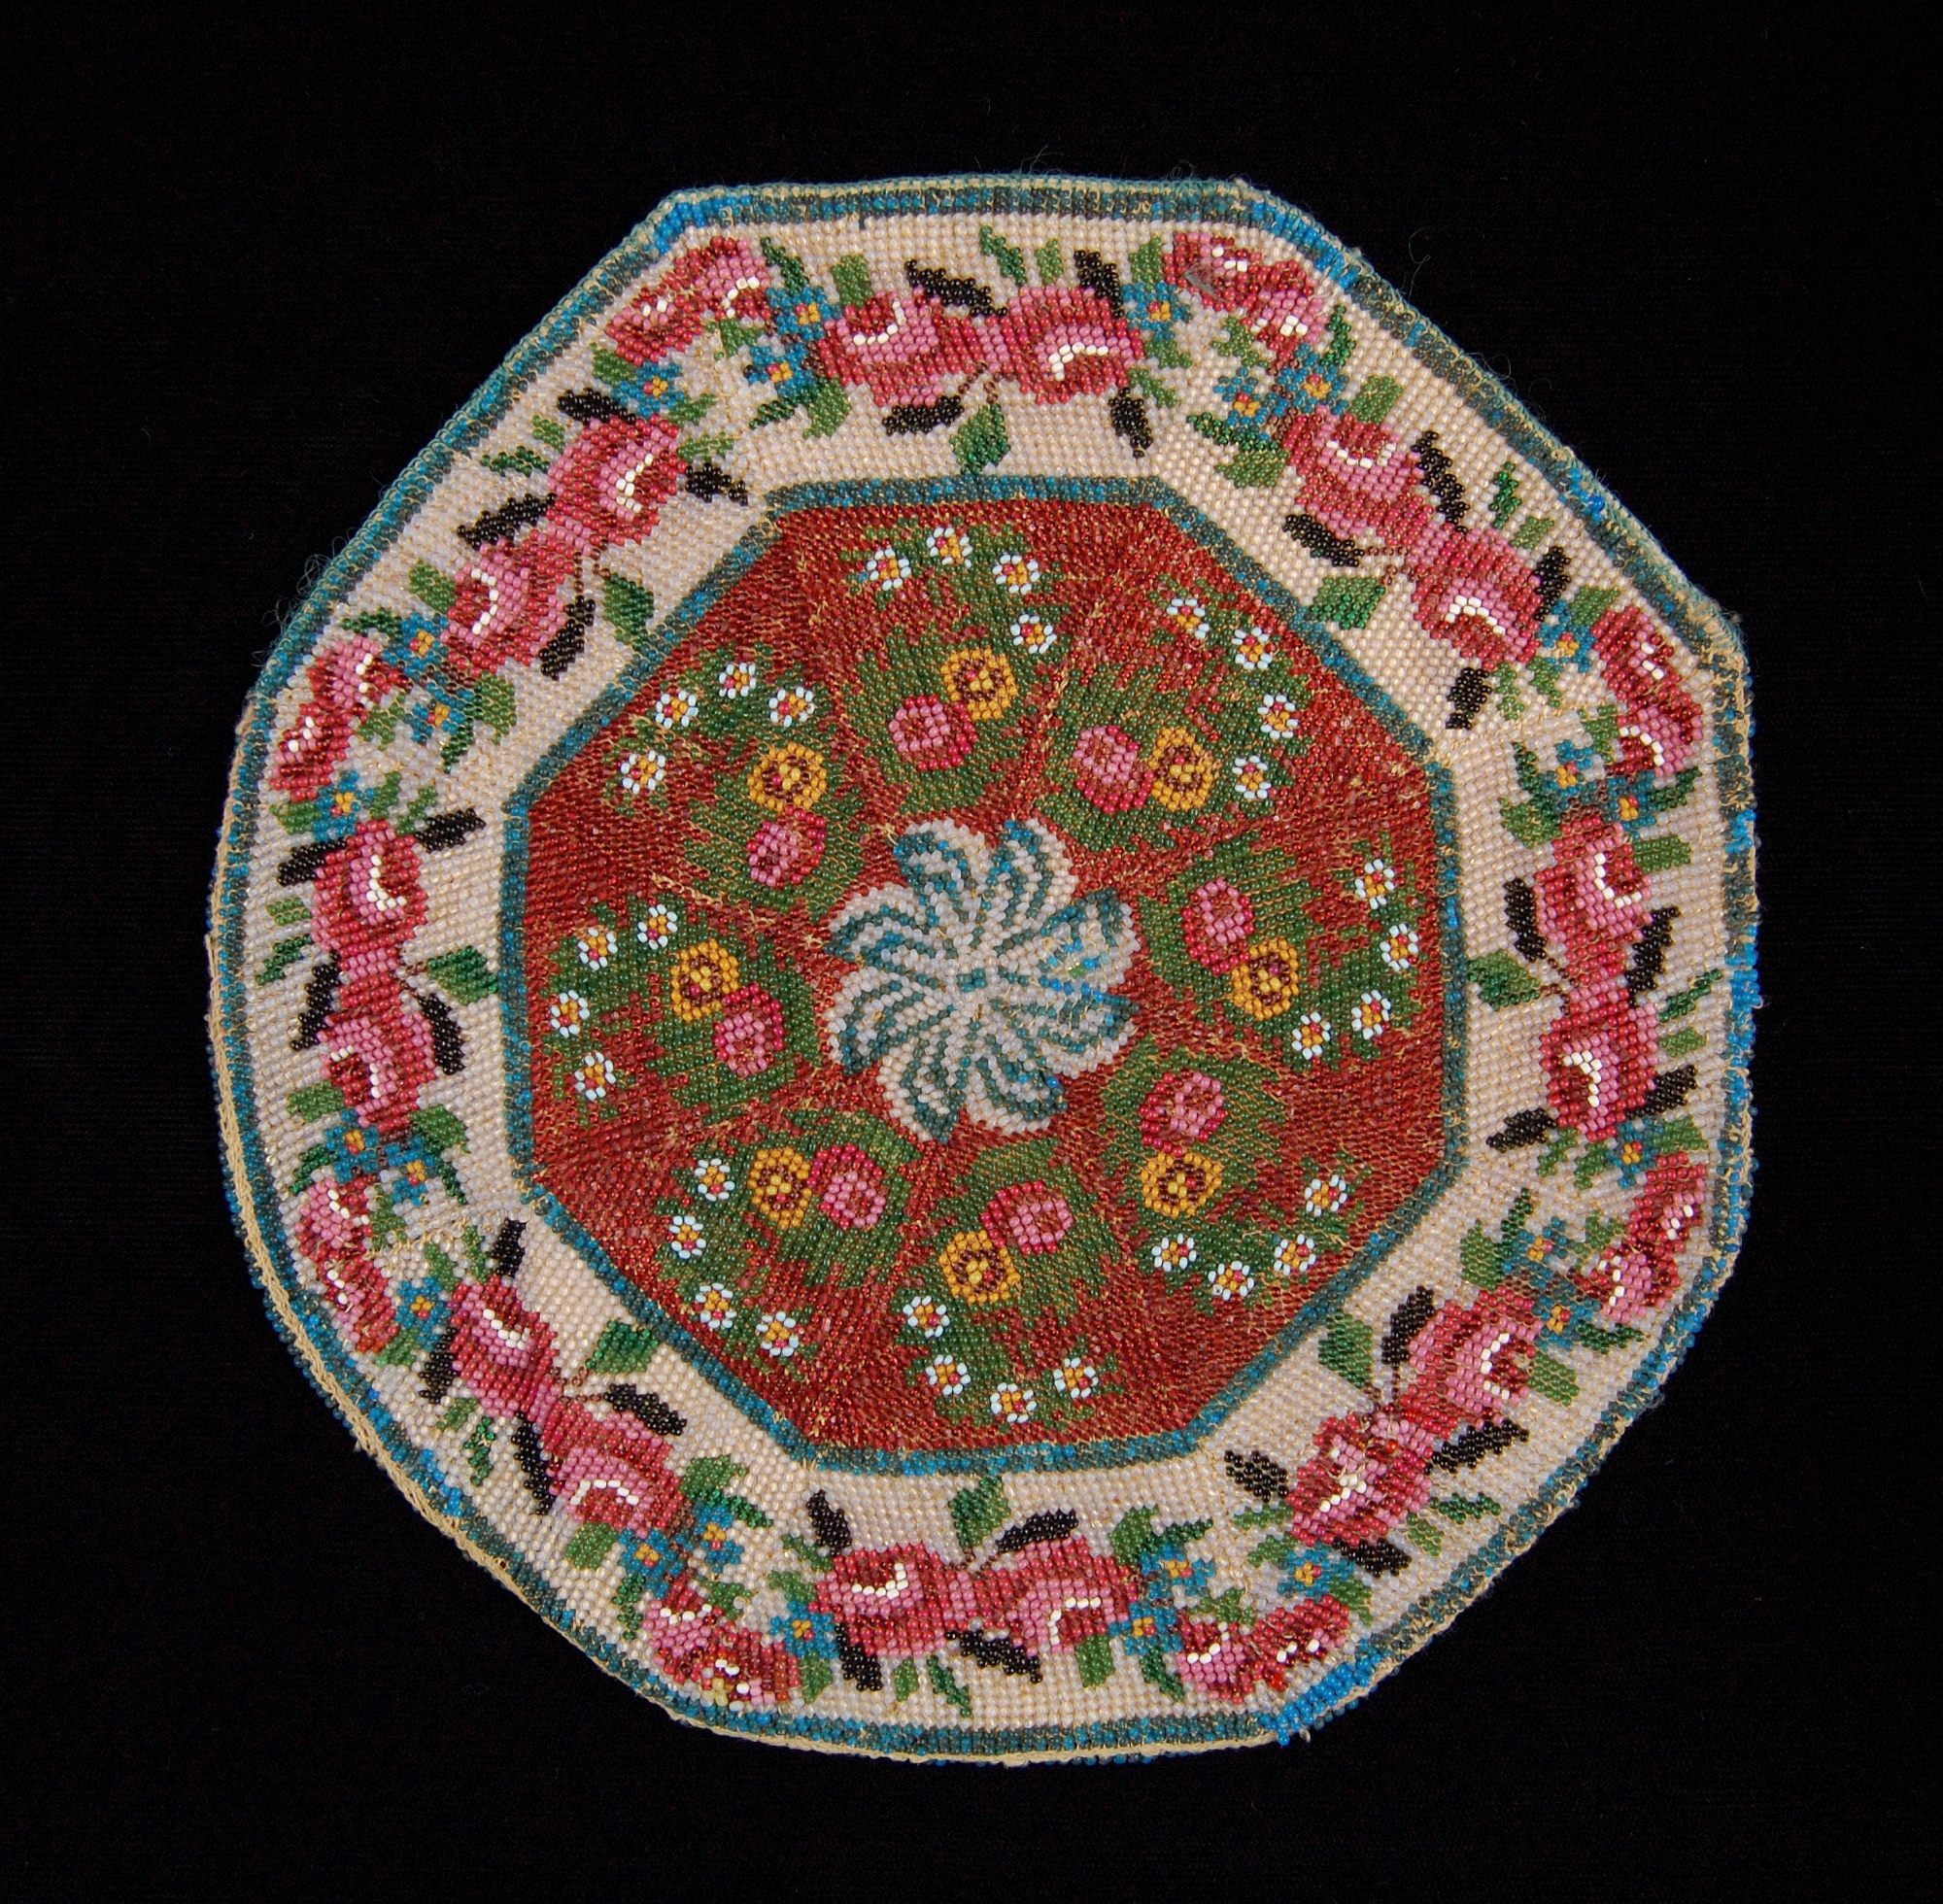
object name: bag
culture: mexican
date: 1830-1860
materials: glass, linen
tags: flowers